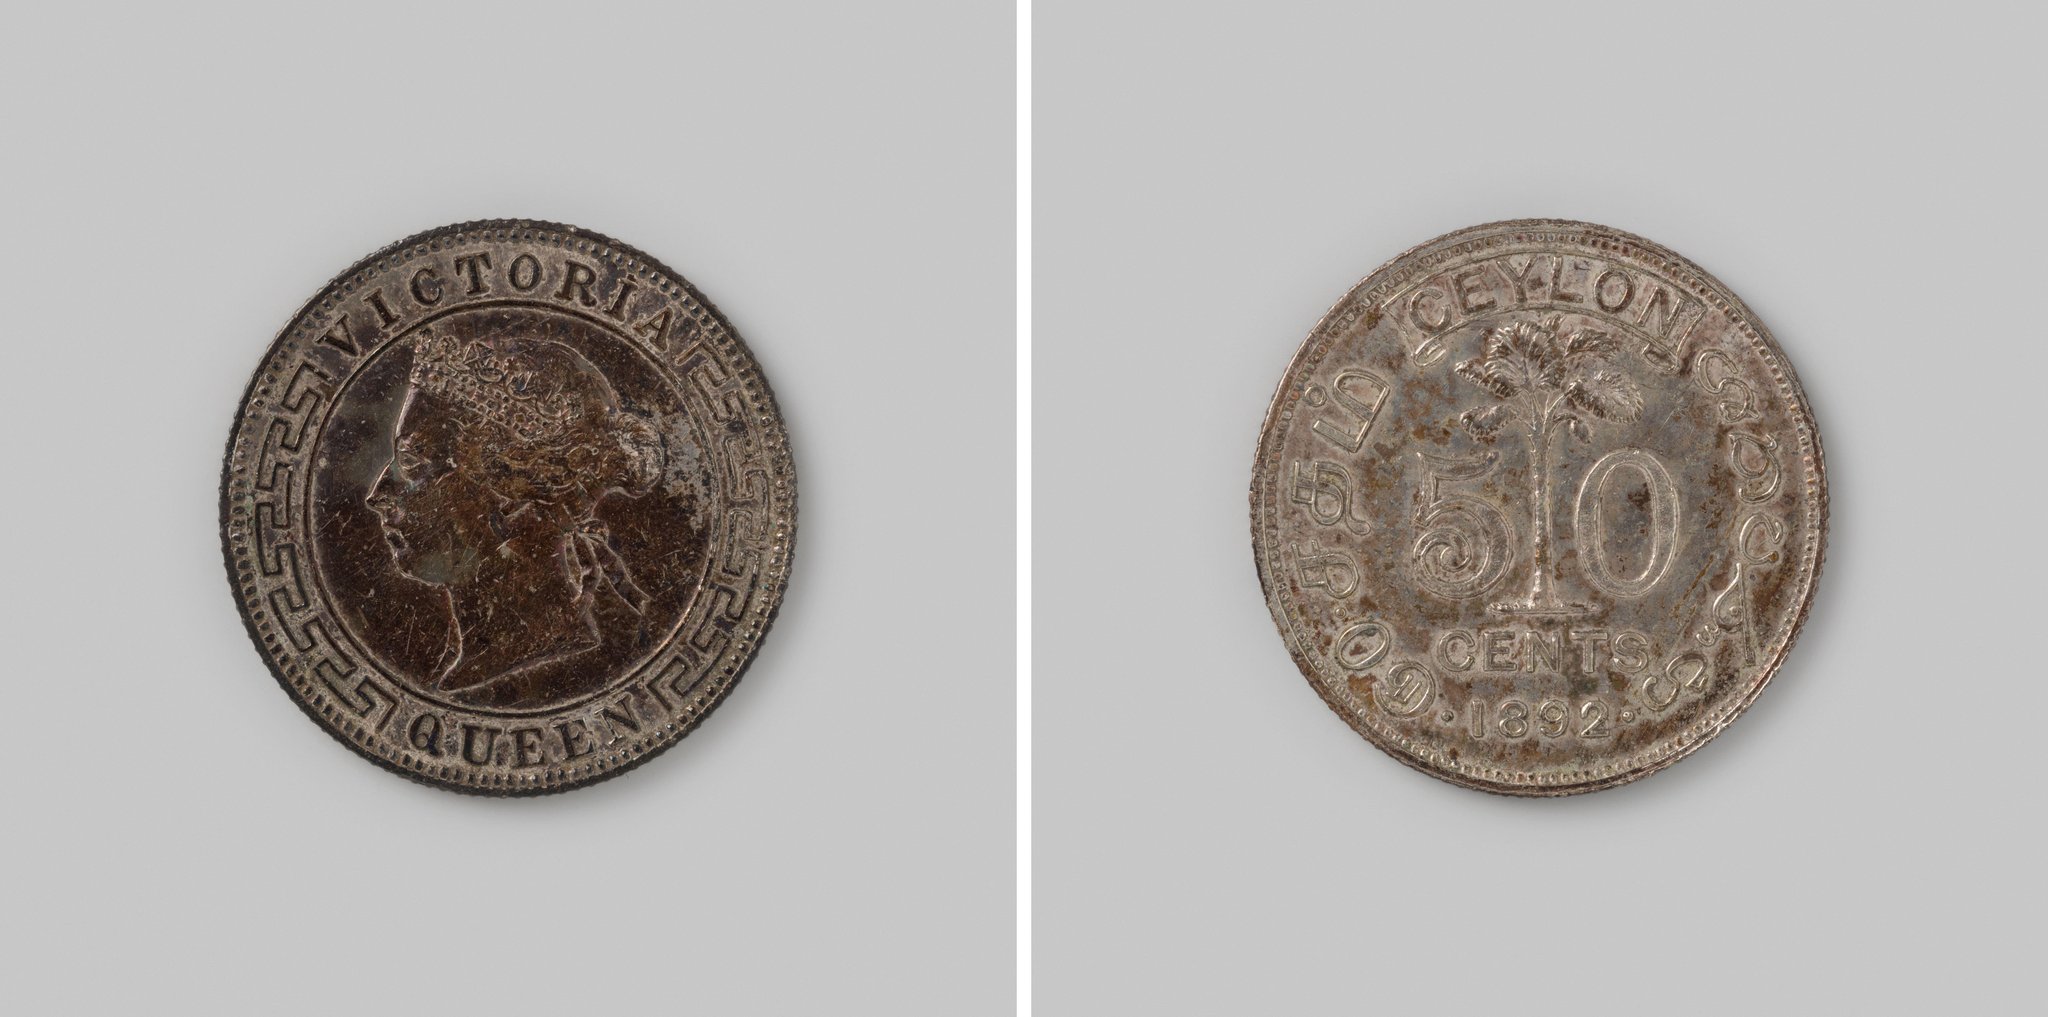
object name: coin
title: 50 cents van Sri Lanka, Ceylon op naam van koningin Victoria, 1892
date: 1892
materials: silver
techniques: striking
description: Zilveren munt. Voorzijde: hoofd met diadeem van de koningin naar links. Keerzijde: tussen waarde-aanduiding - in twee regels - palmboom. Jaartal onderaan. Kartelrand.